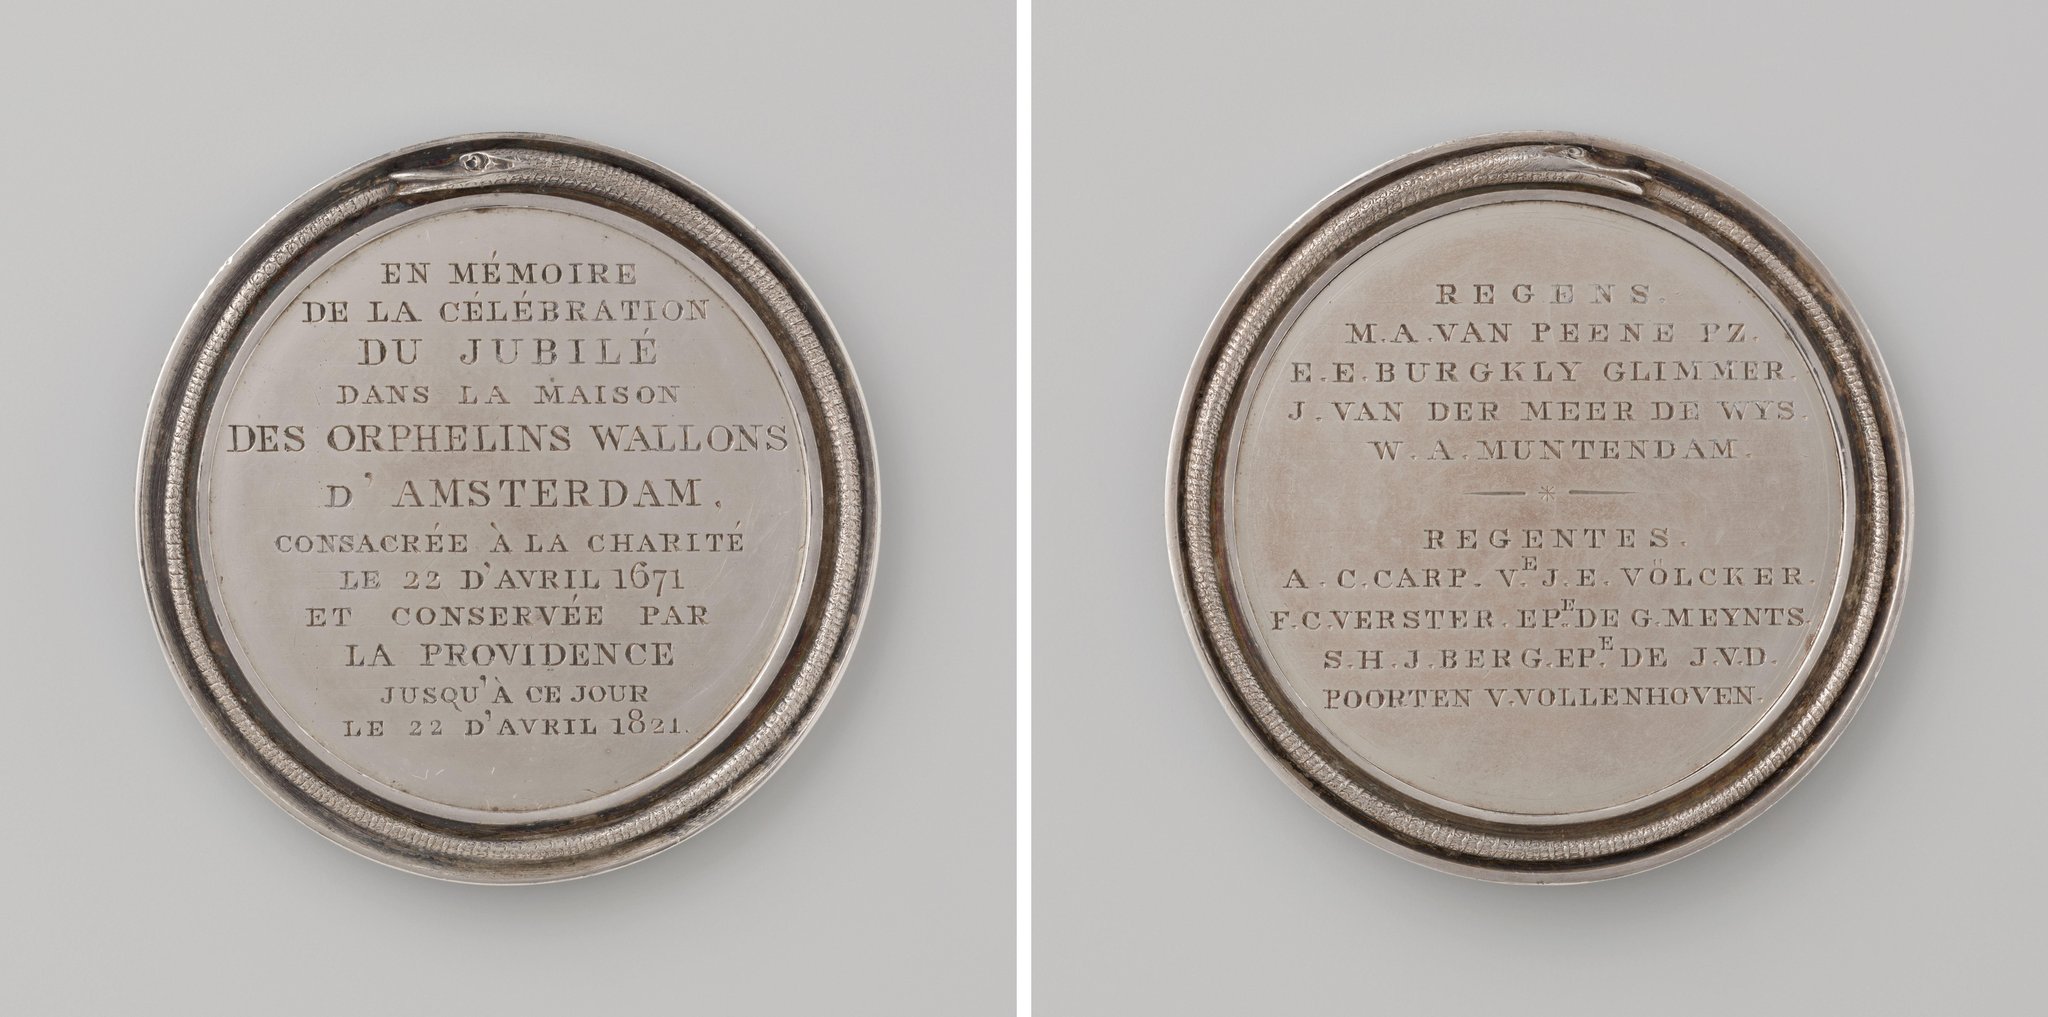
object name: history medal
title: Honderdvijftigjarig bestaan van het weeshuis der Waalse gemeente te Amsterdam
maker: Anonymous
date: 1821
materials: silver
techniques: engraving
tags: amsterdam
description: Zilveren penning. Voorzijde: opschrift binnen slangerond. Keerzijde: opschrift binnen slangerond; randschrift